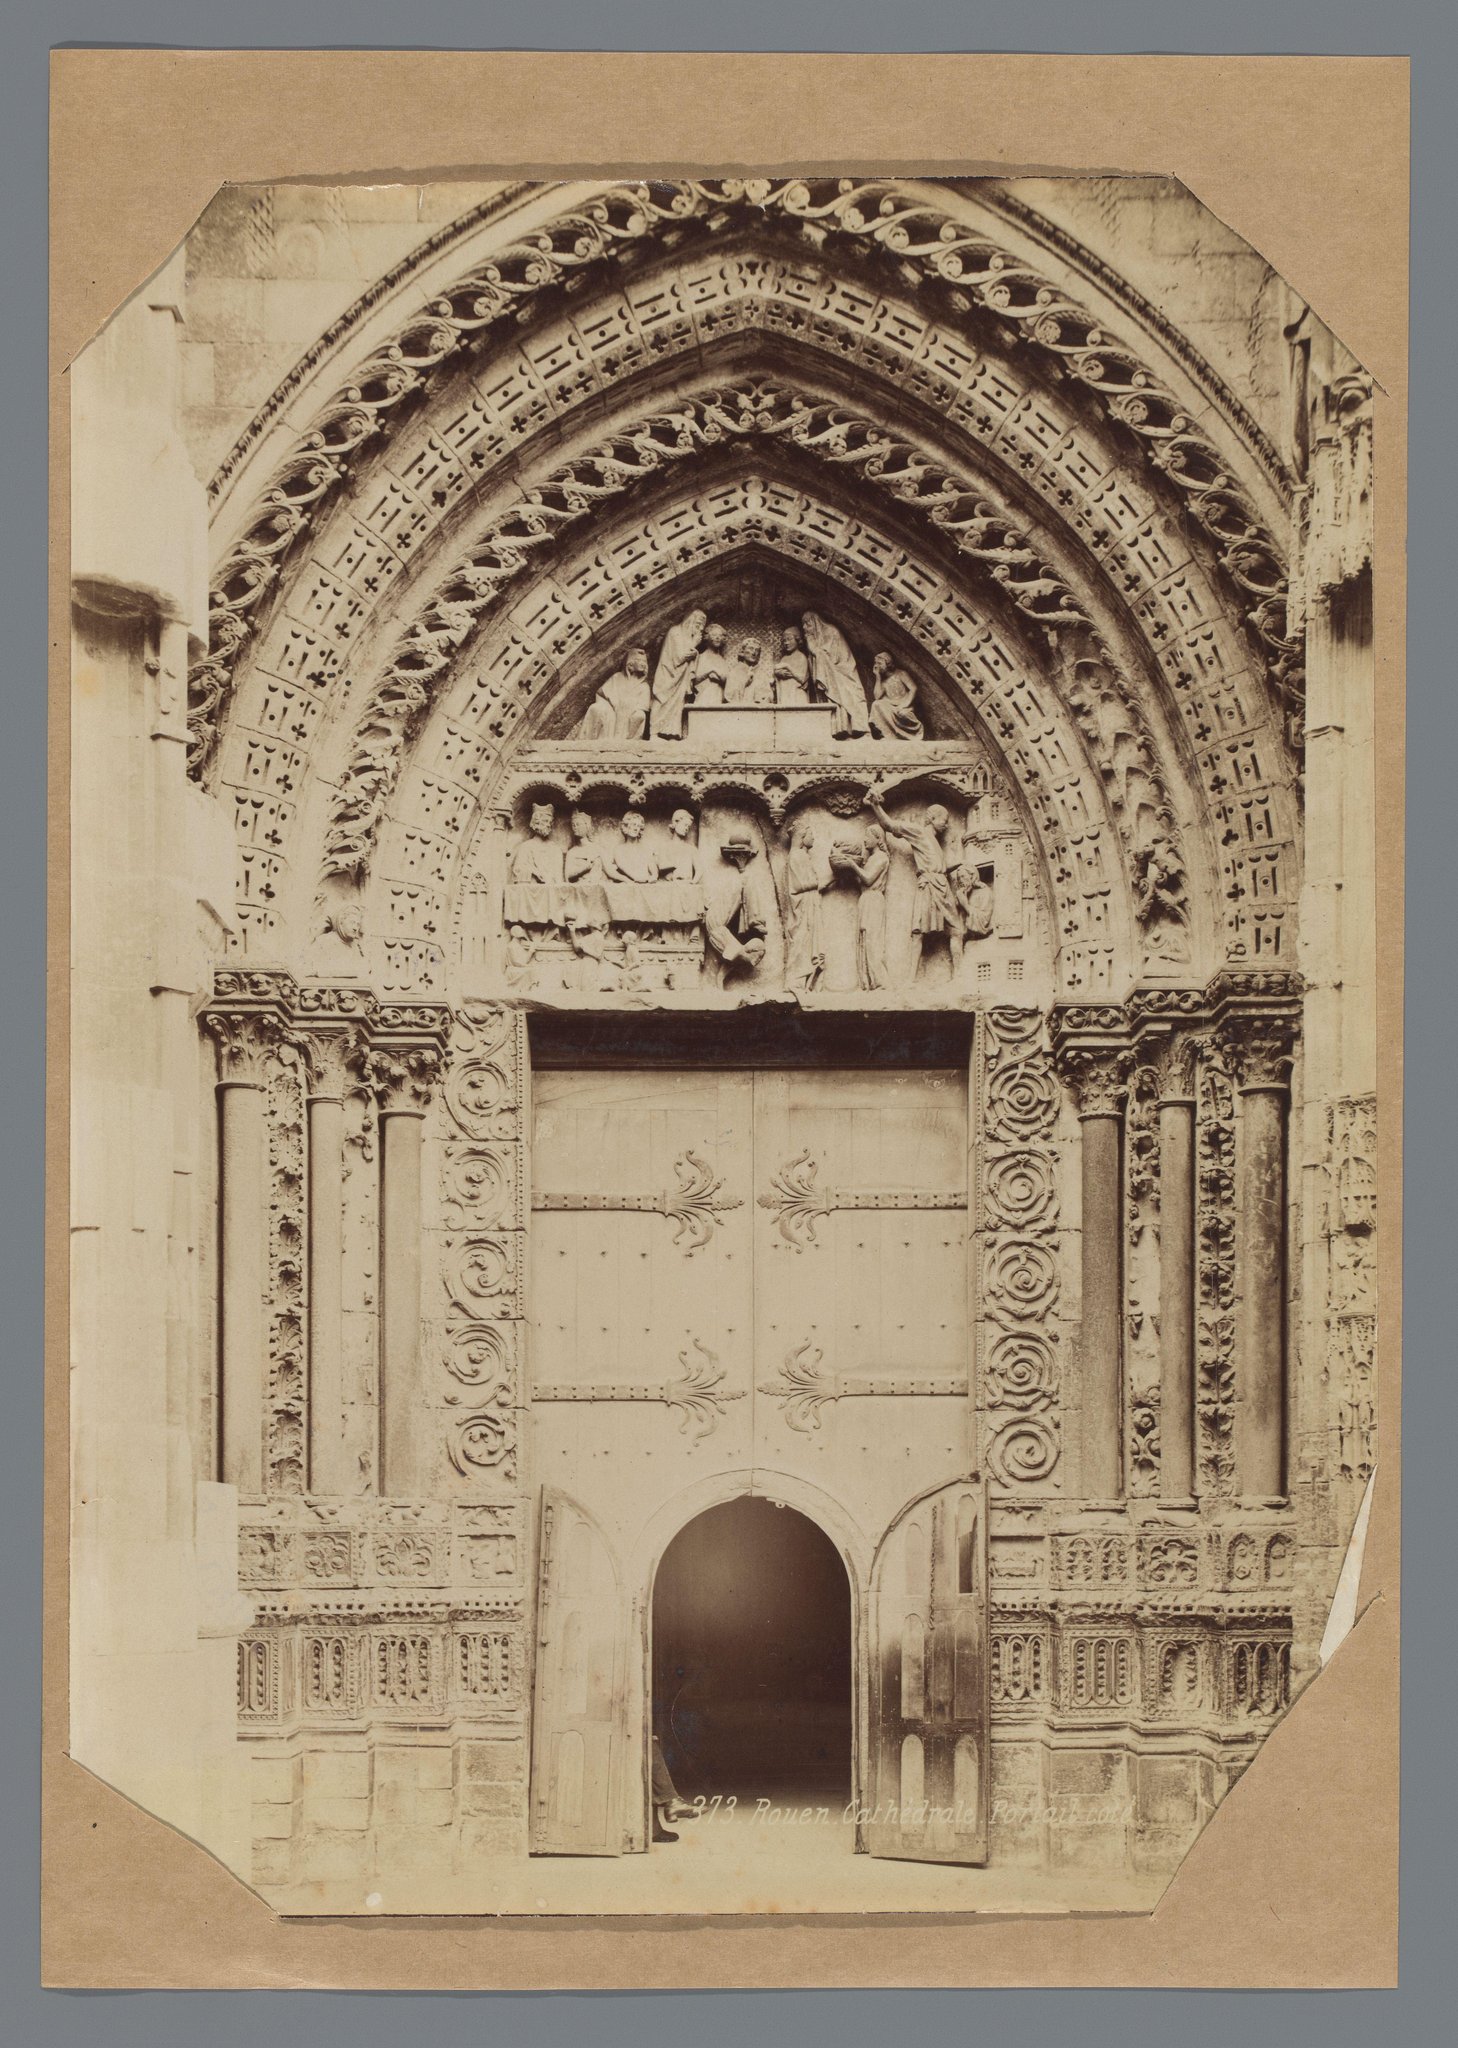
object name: photograph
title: Frankrijk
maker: Anonymous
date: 1850-1880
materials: photographic support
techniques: albumen print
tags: france